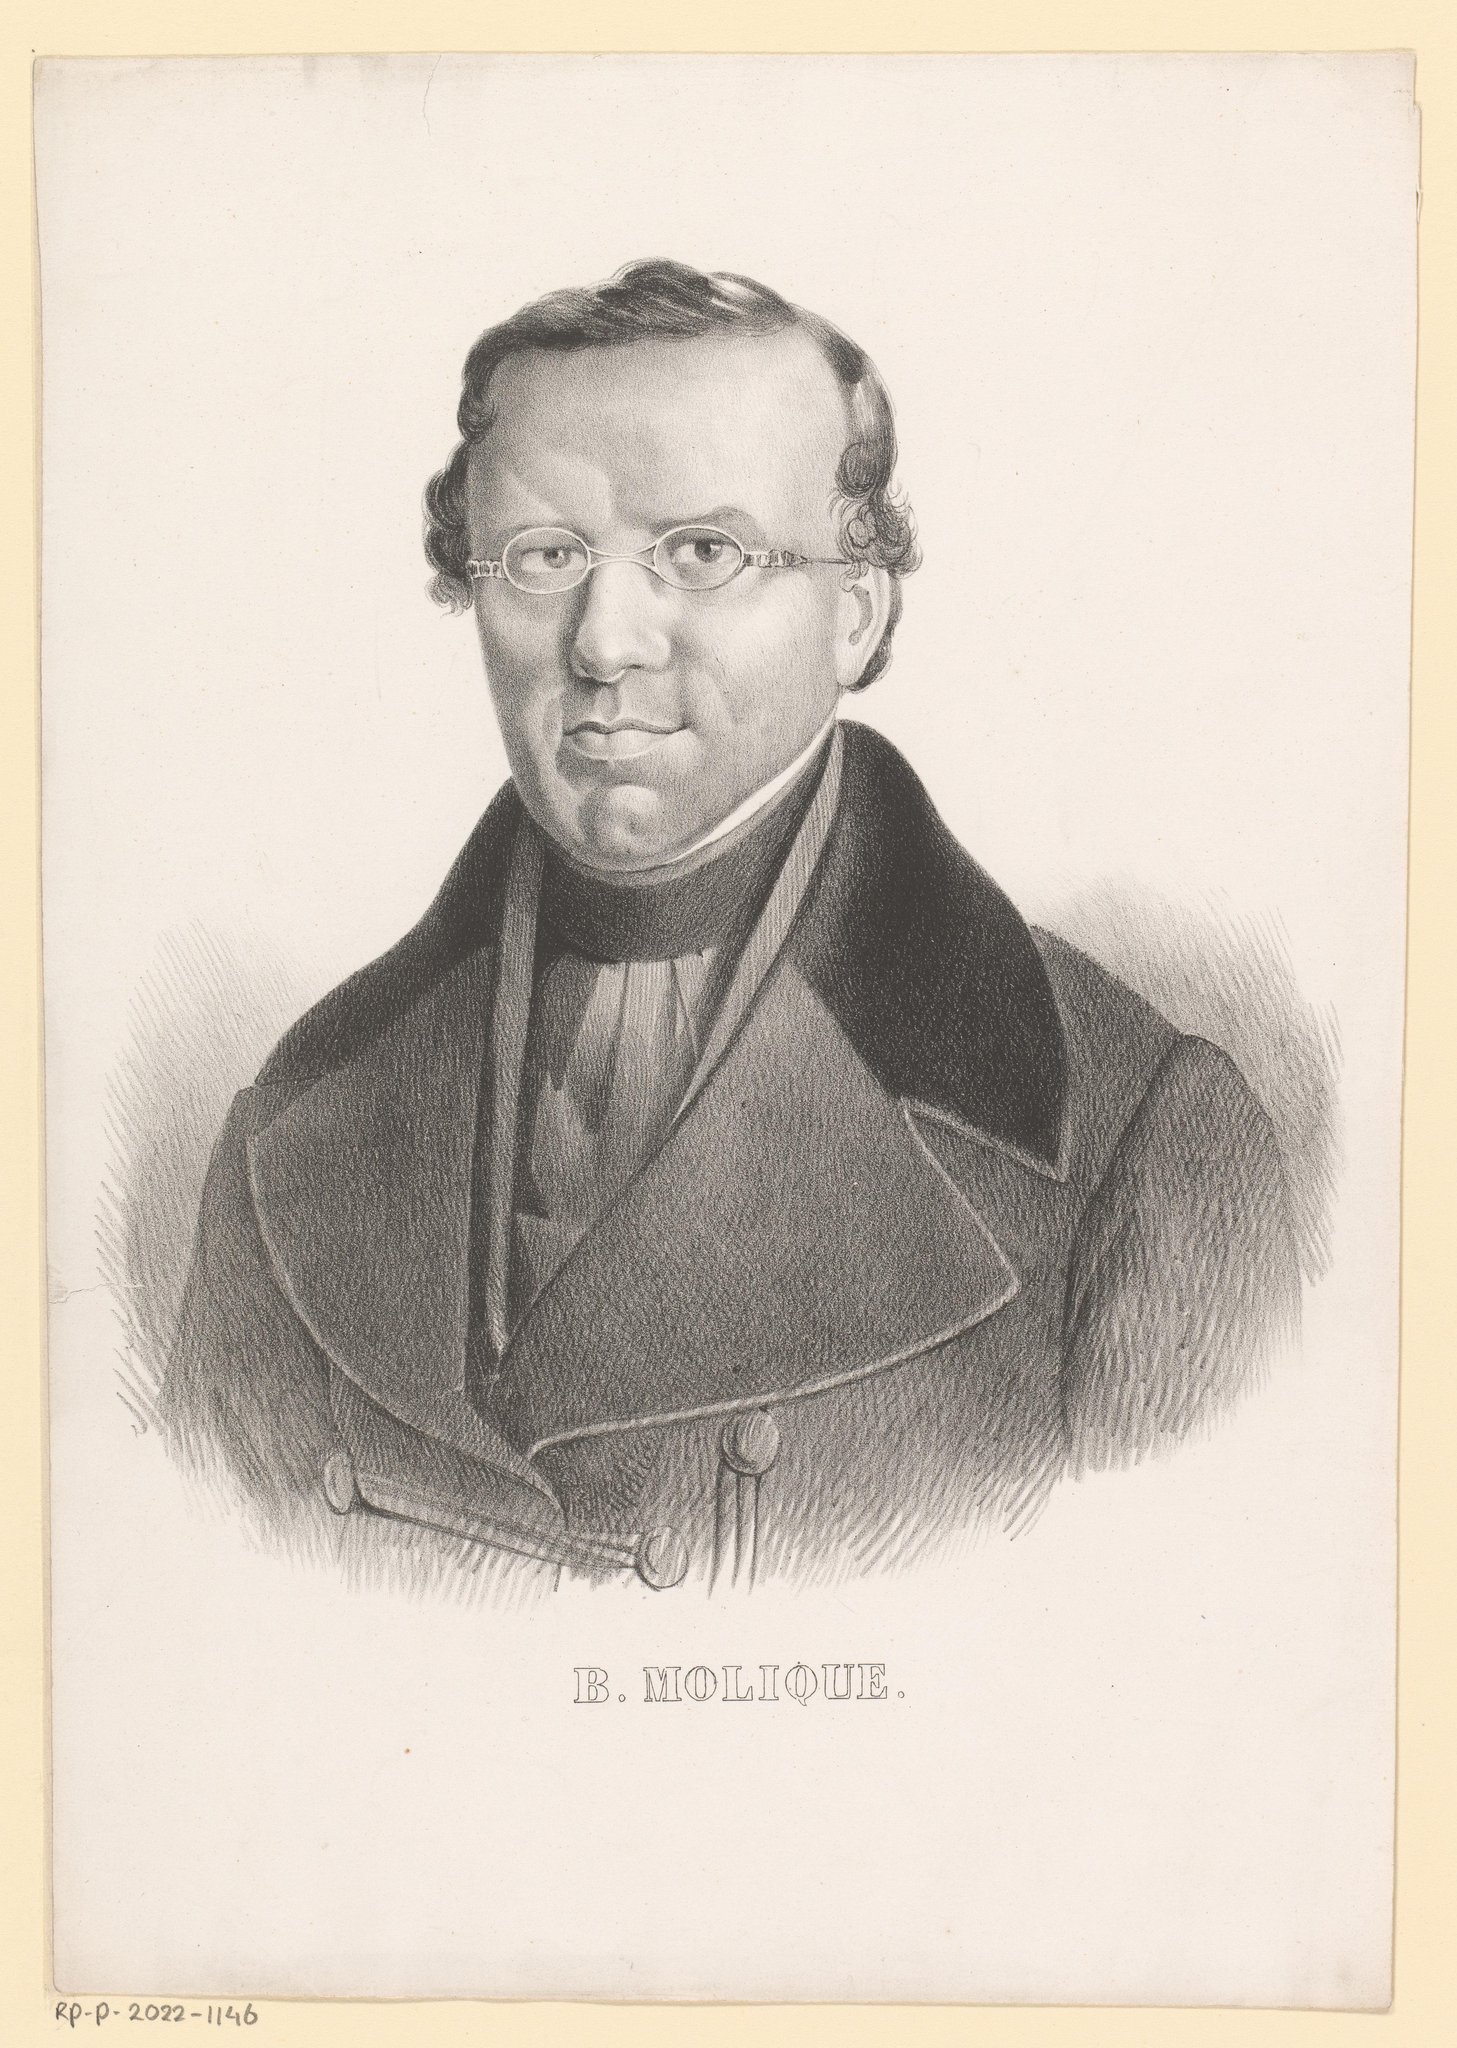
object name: print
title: Portret van Bernhard Molique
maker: Anonymous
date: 1820-1900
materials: paper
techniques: lithograph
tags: eyeglasses, spectacles, historical persons